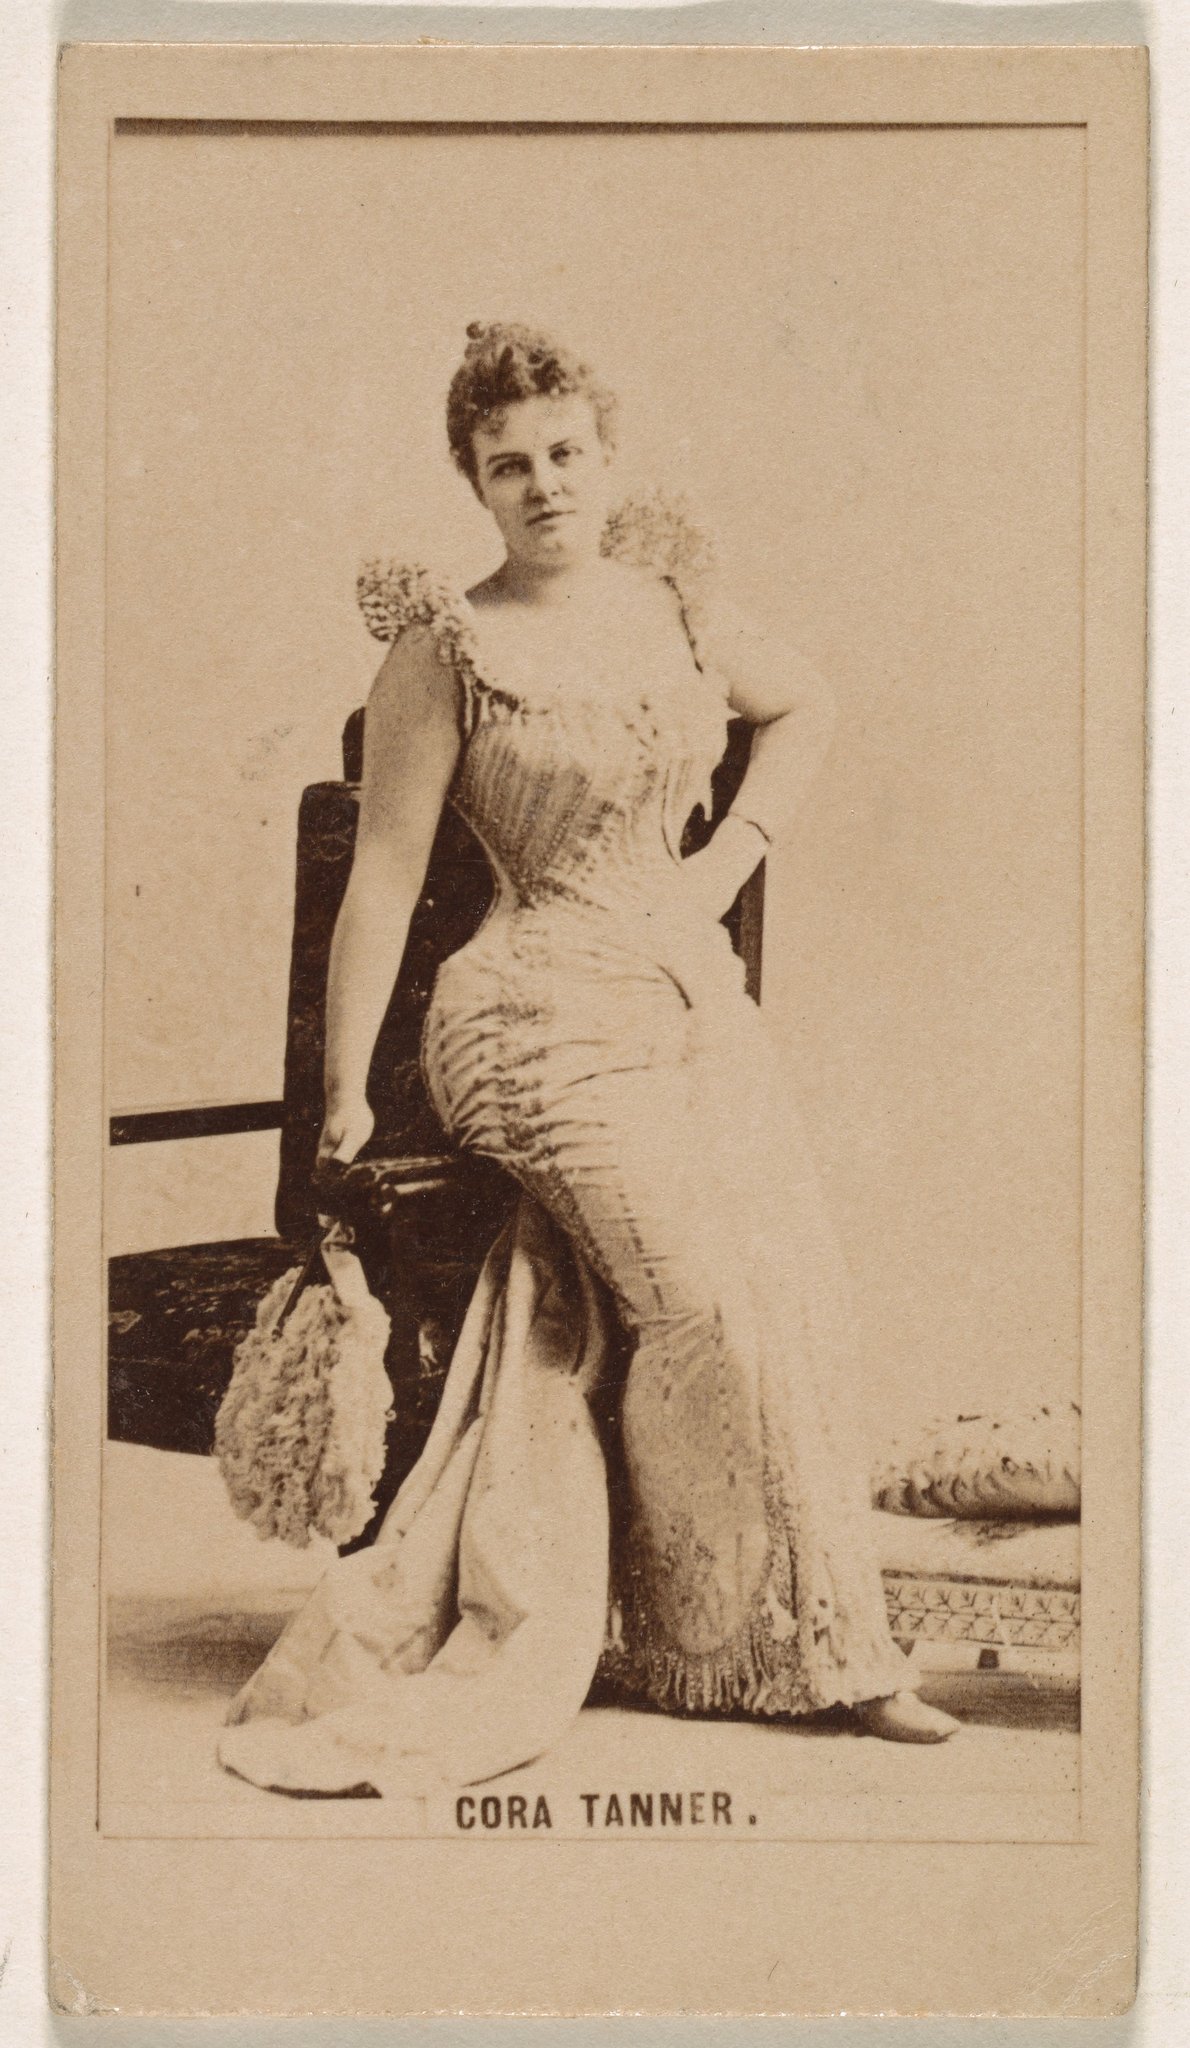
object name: photograph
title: Cora Tanner, from the Actresses series (N245) issued by Kinney Brothers to promote Sweet Caporal Cigarettes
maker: kinney brothers tobacco company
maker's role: publisher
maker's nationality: american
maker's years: 1869-2011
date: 1890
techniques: albumen silver print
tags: portraits,women,actresses